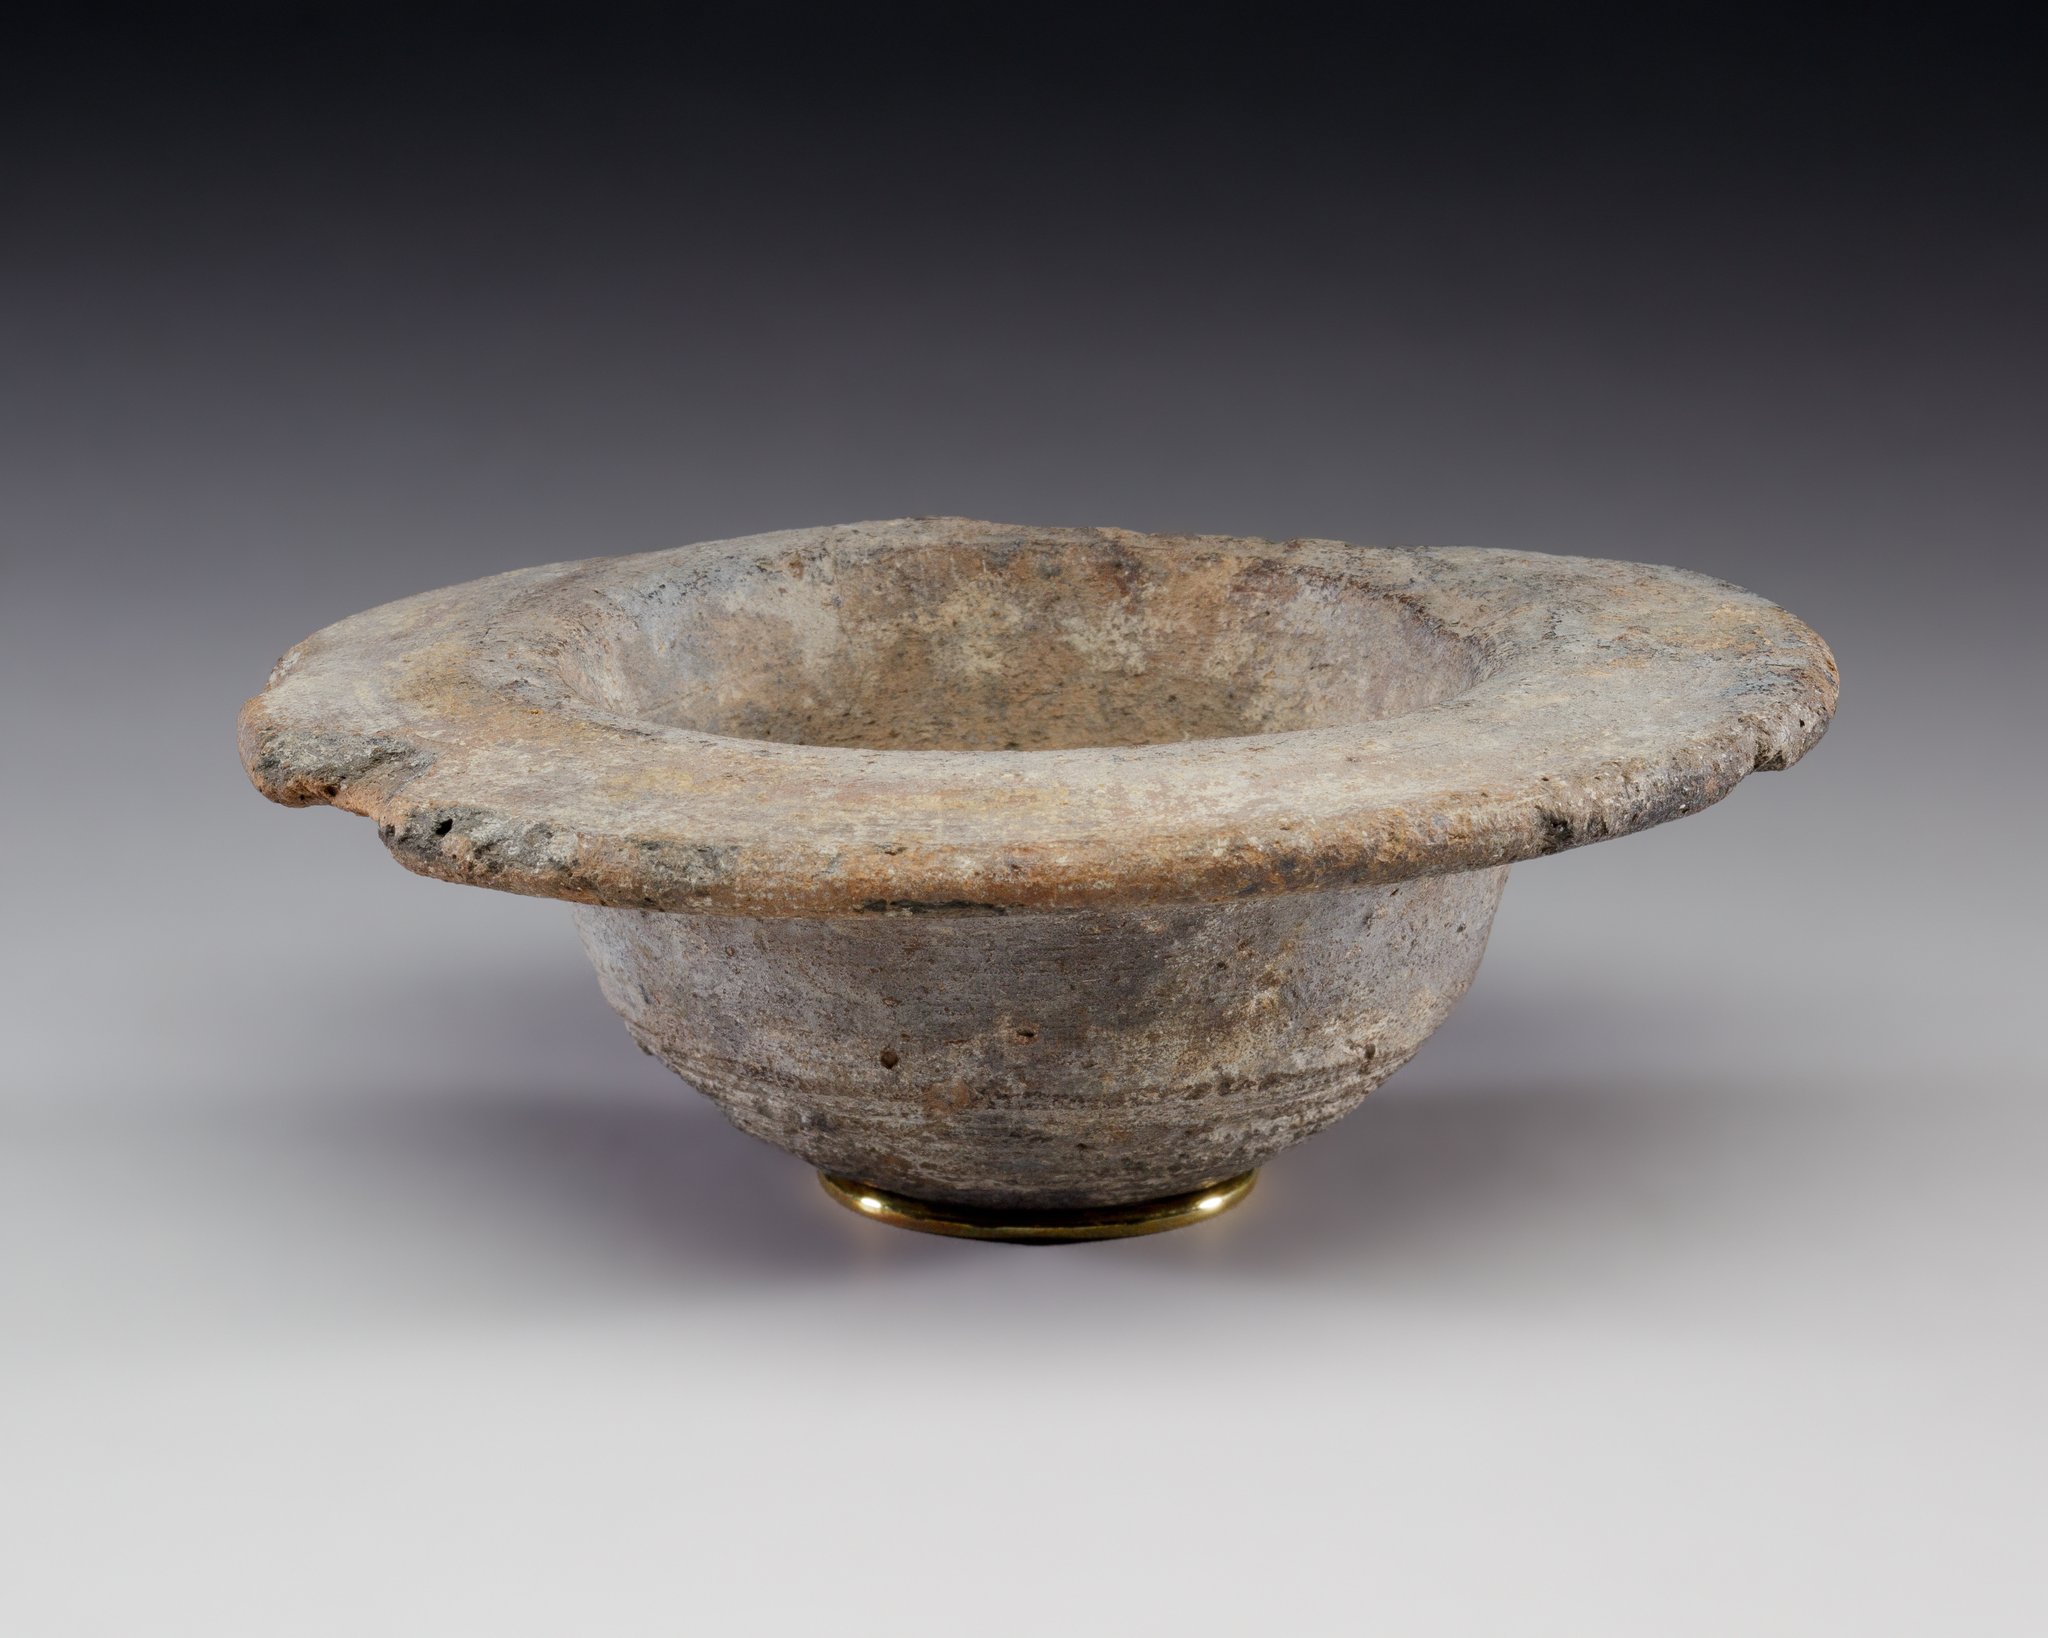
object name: lamp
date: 1479-1458 BCE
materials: pottery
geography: egypt